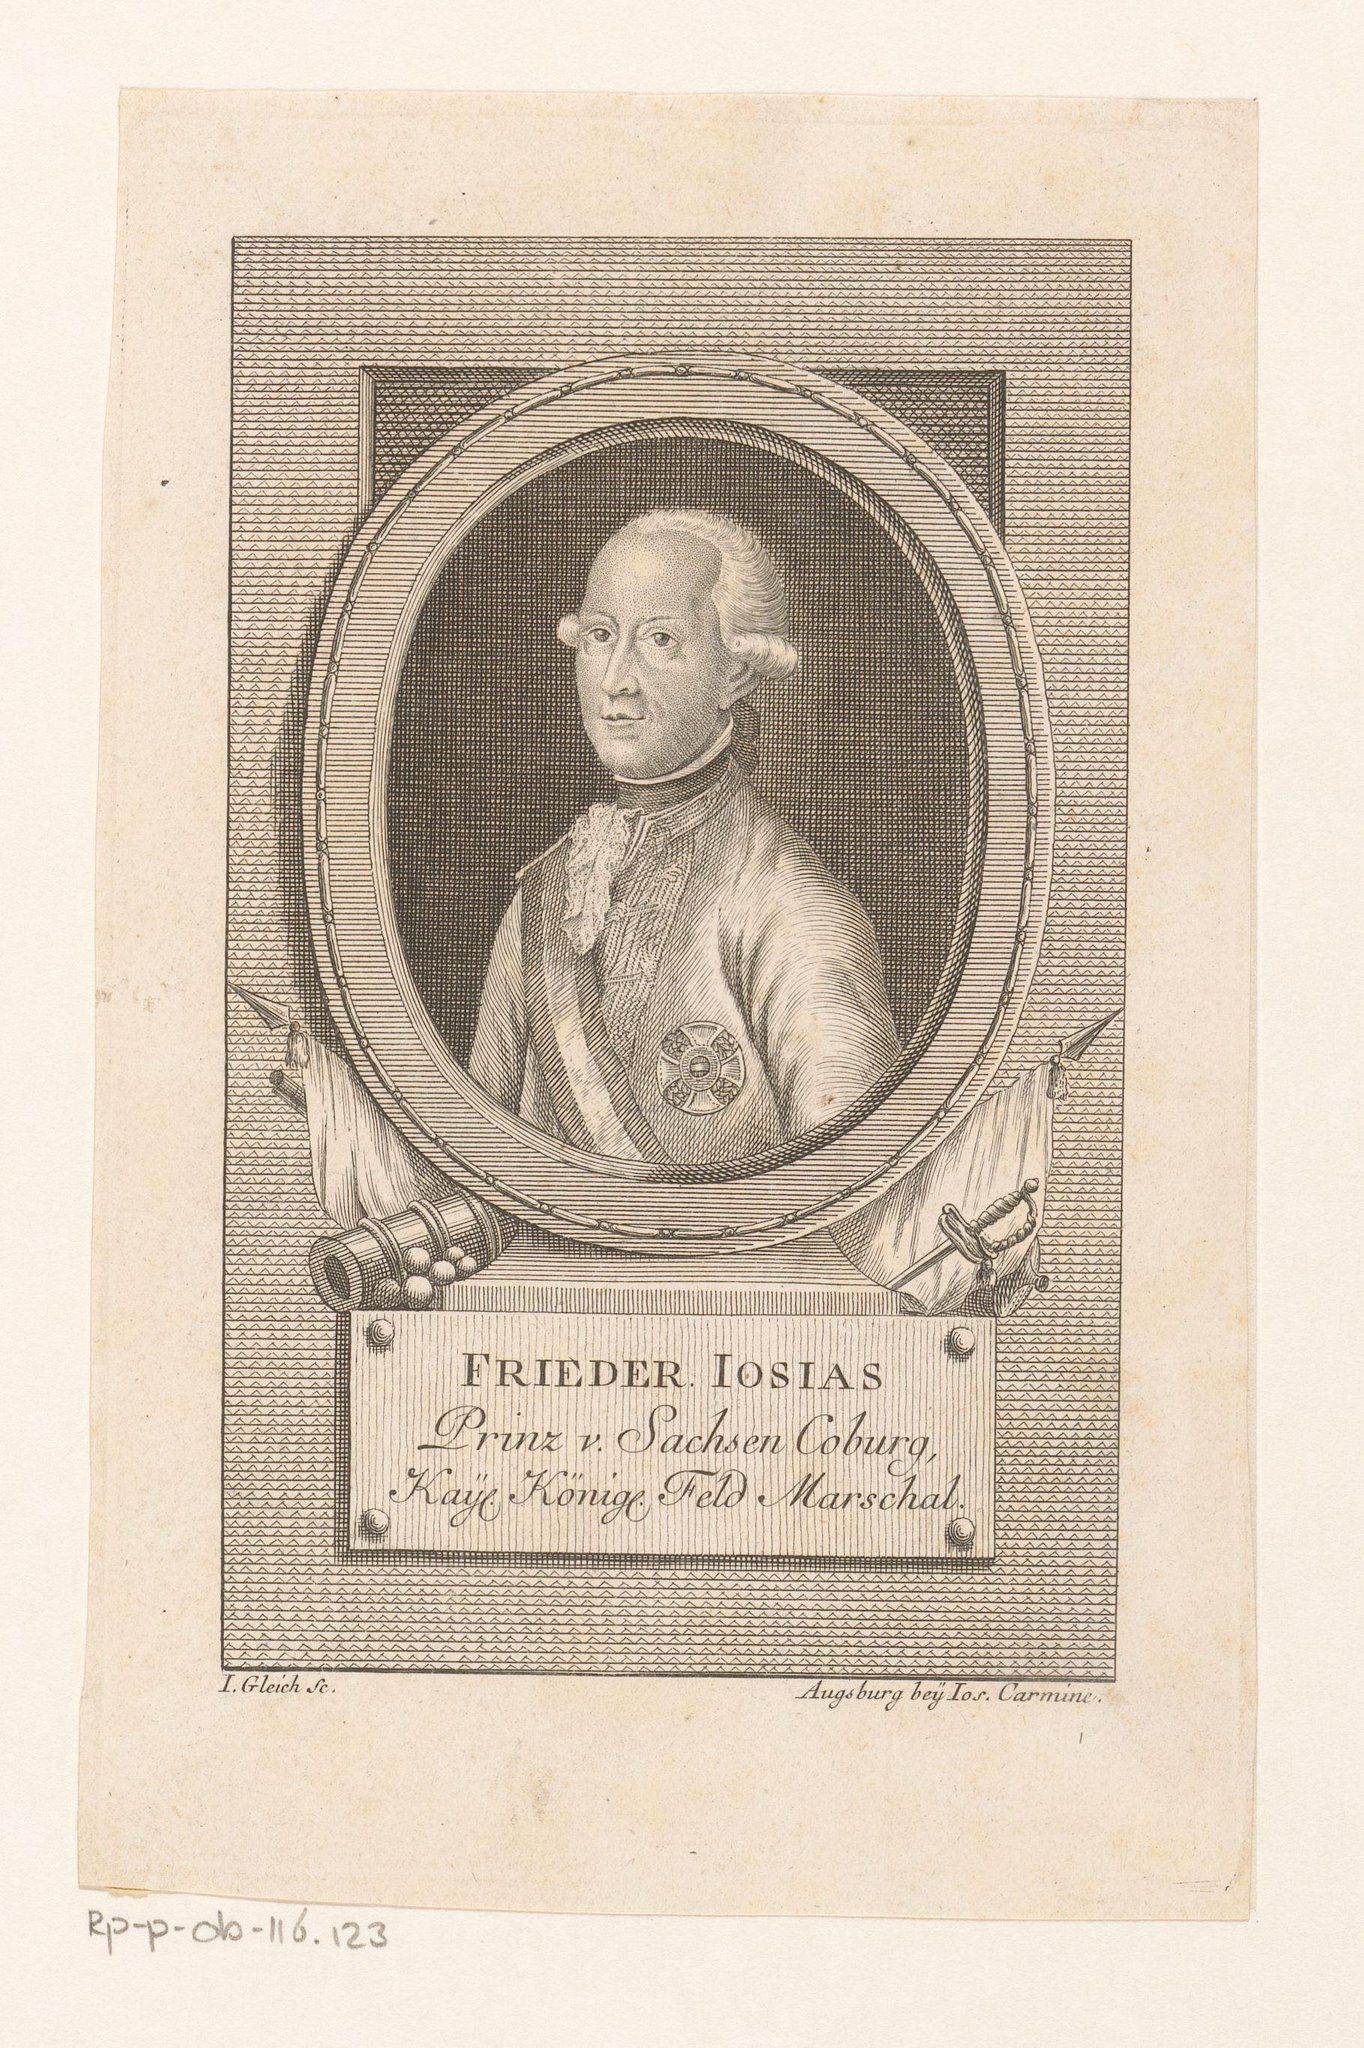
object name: print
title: Portret van Friedrich Josias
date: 1770-1815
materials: paper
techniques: engraving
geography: augsburg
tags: prince, historical persons, symbols, allegories of war; 'guerra' (ripa)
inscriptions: collector's mark: Lugt 2228